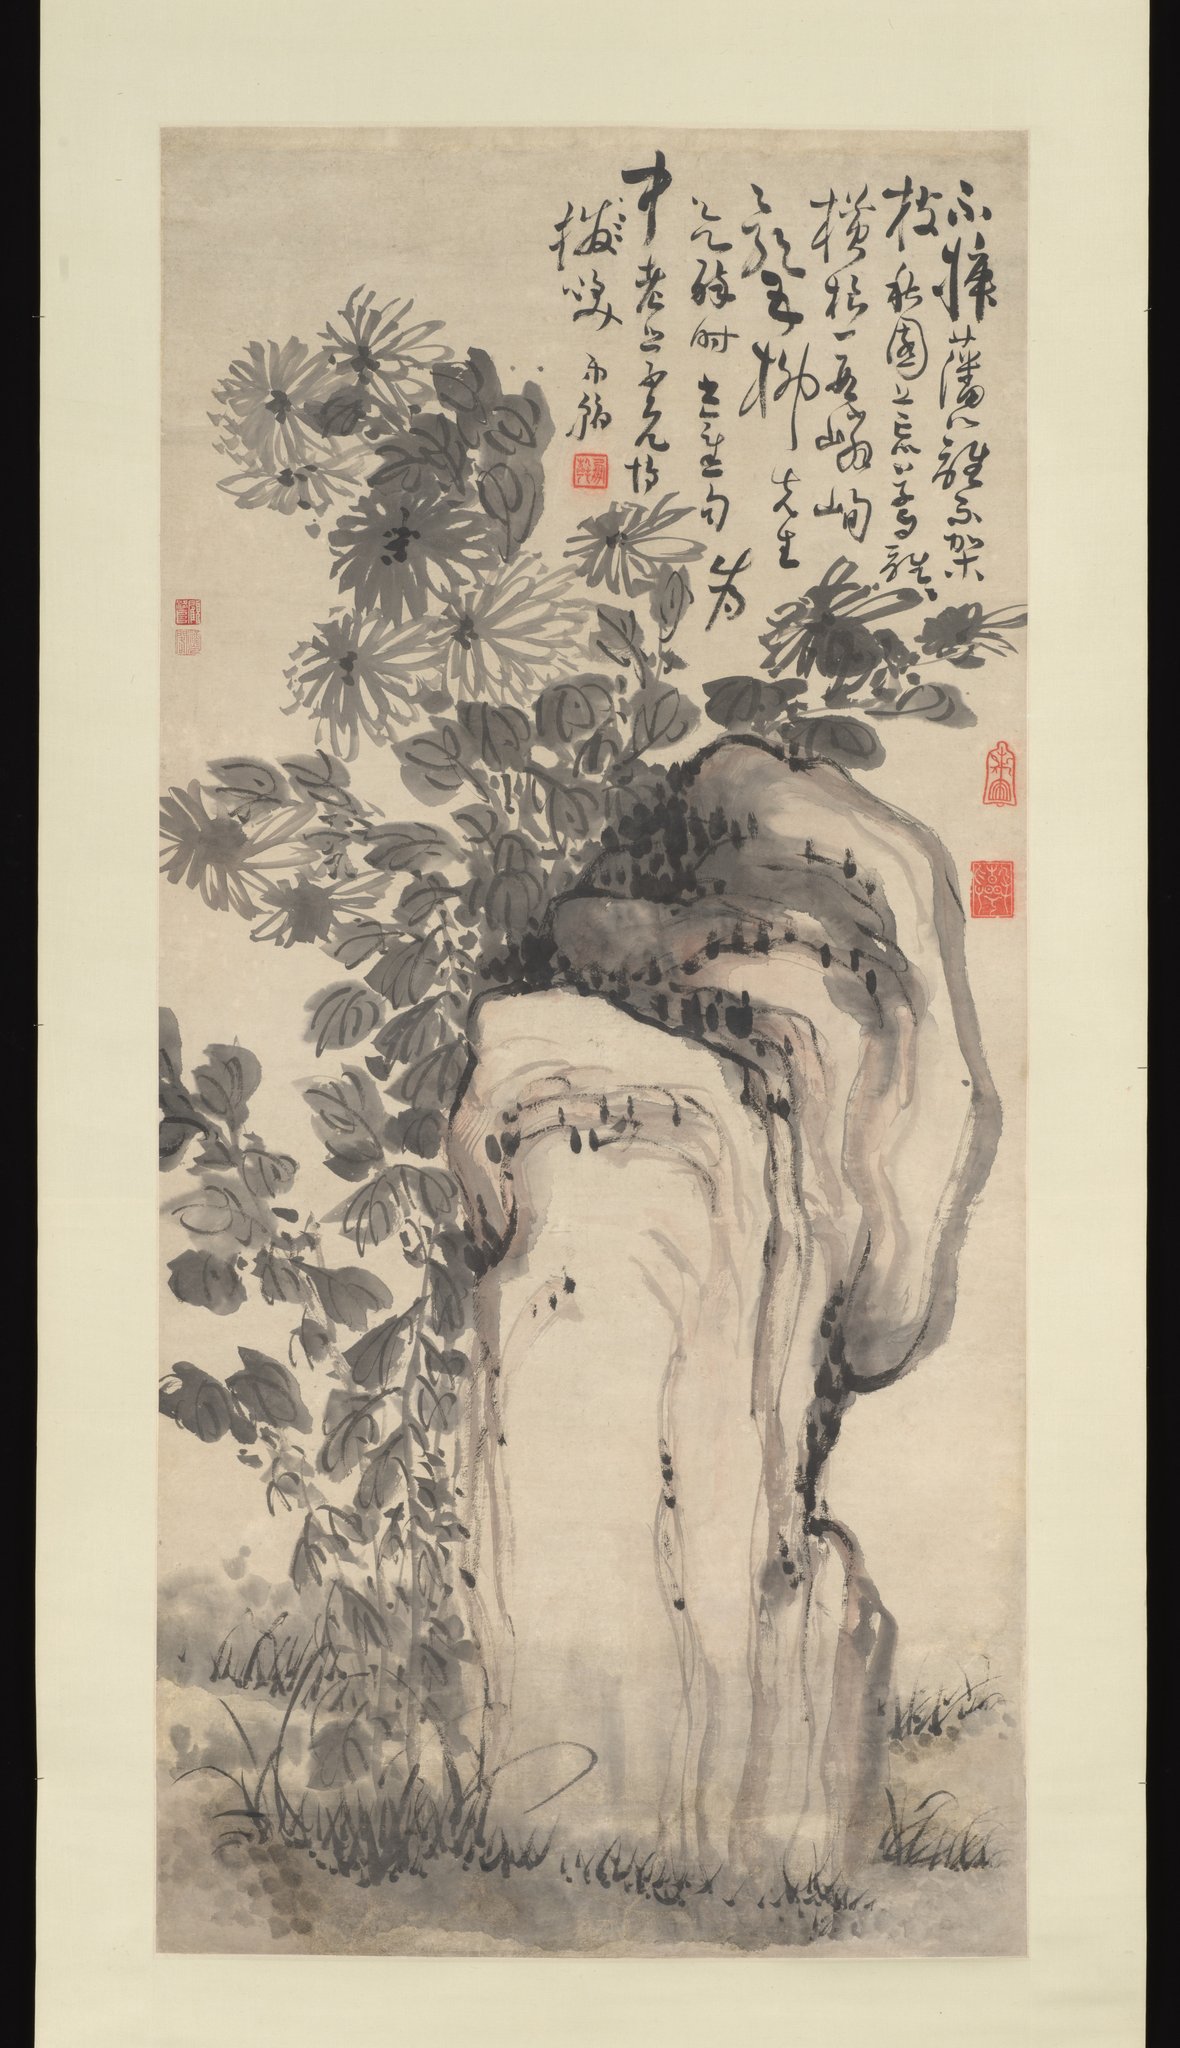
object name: hanging scroll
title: Chrysanthemums by a rock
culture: chinese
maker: gao fenghan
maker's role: artist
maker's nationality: chinese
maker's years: 1683-1748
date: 1701-1800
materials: ink, paper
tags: flowers